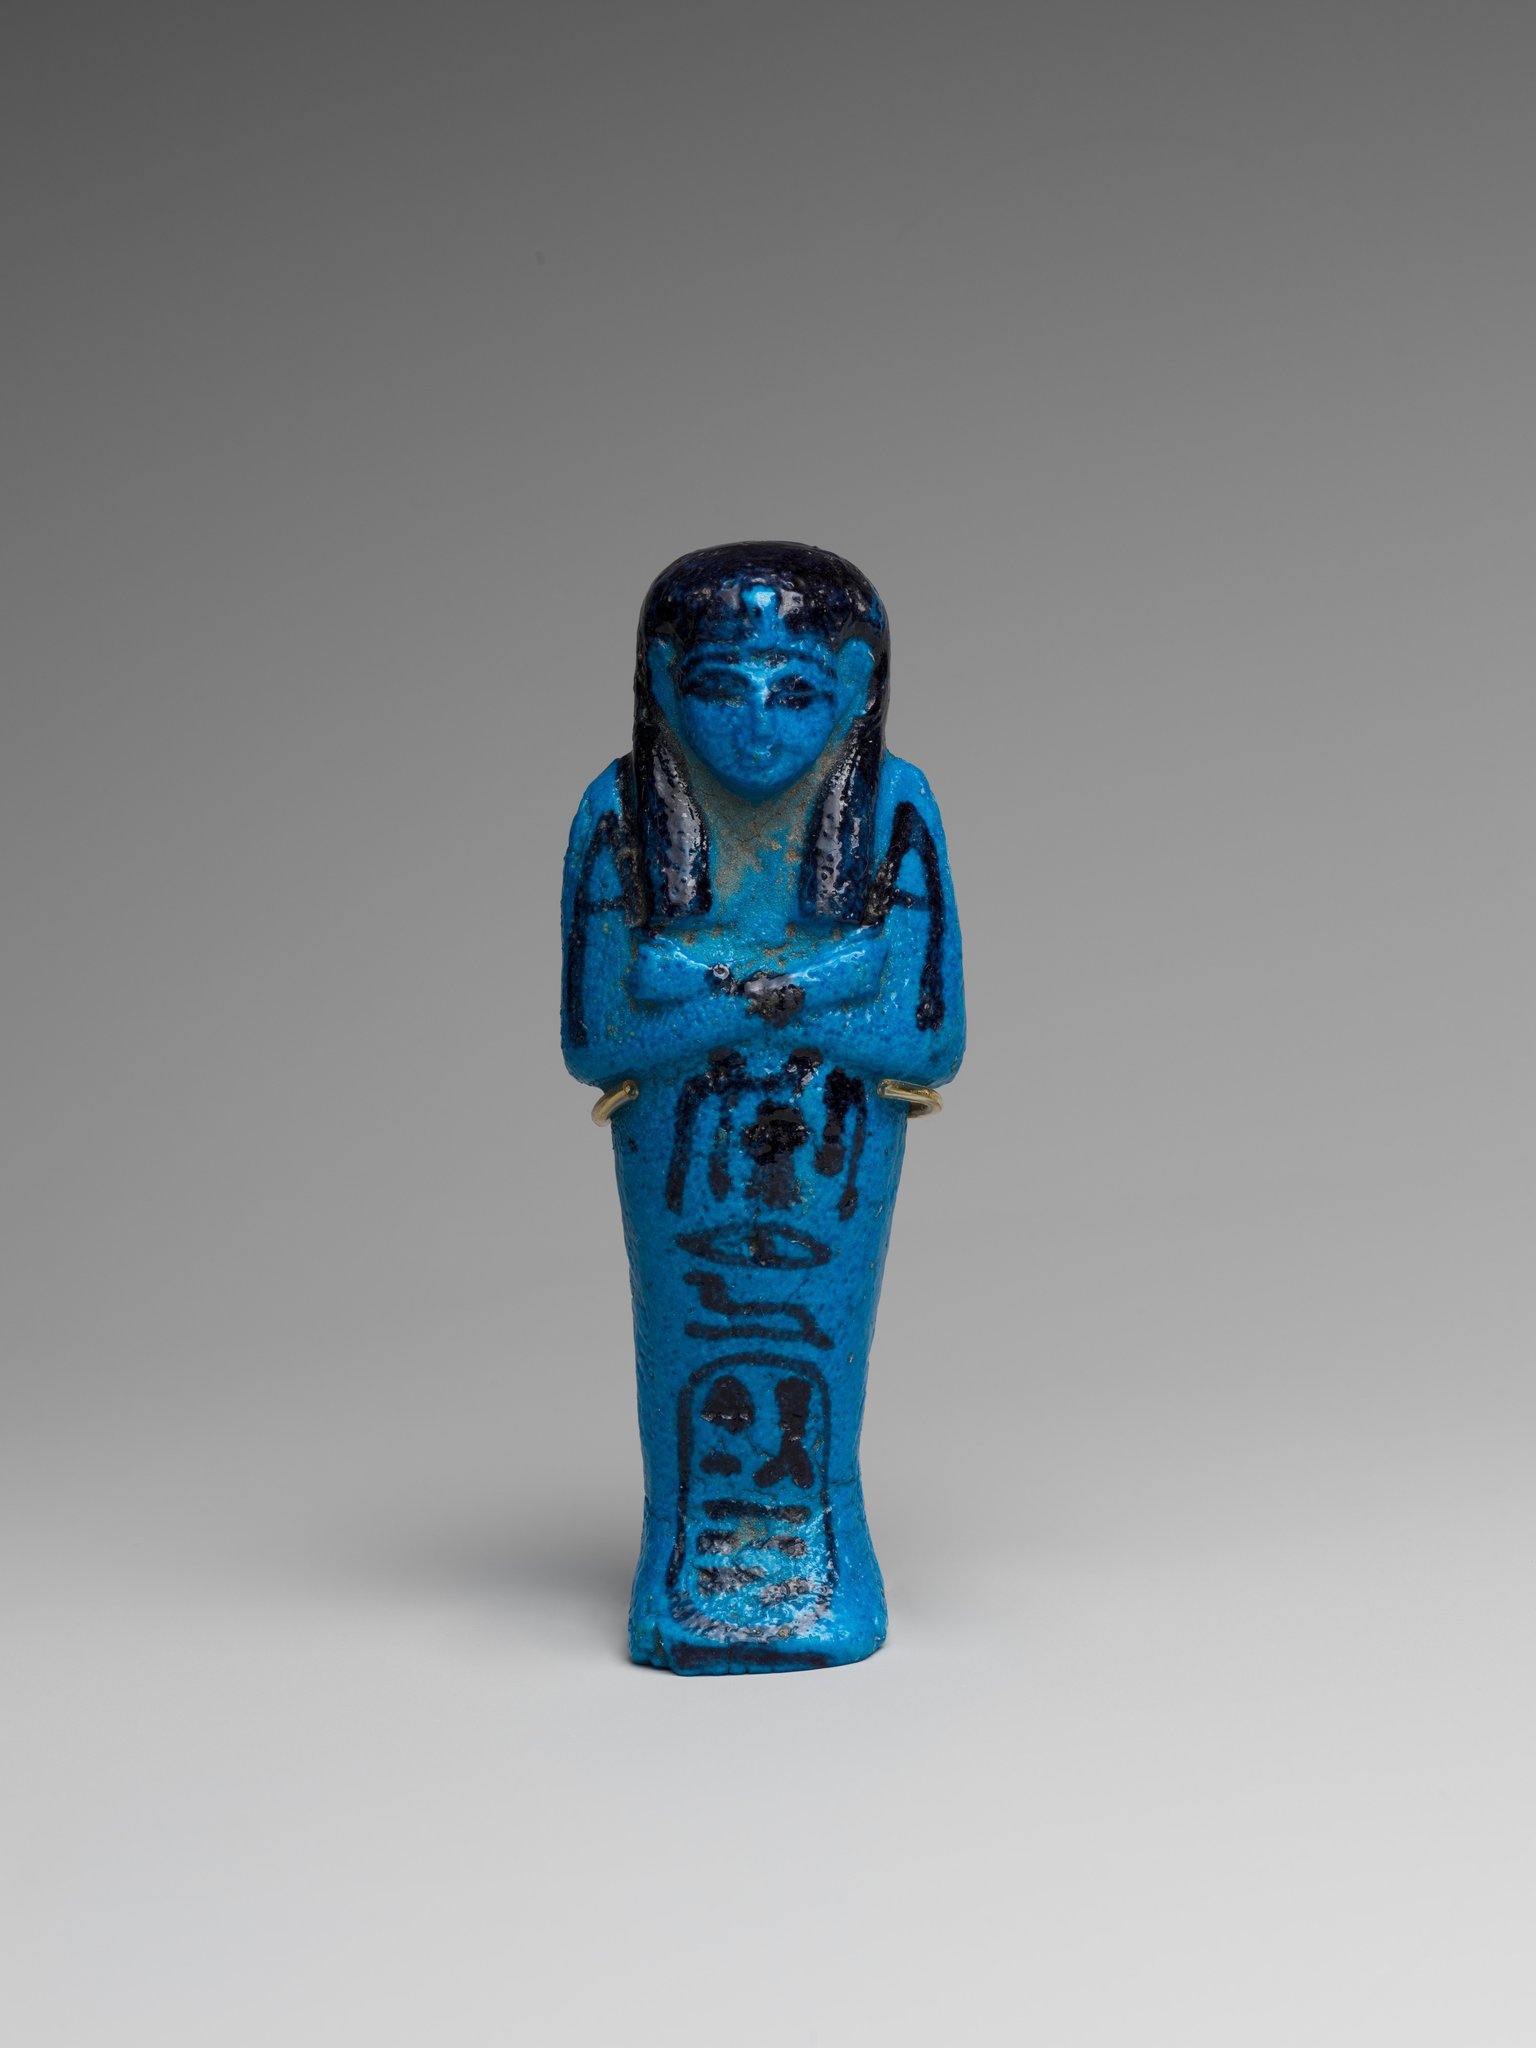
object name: shabti, queen henettawy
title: Shabti of the Adoratrice of Hathor ("Duahathor") Henettawy, wife of Painedjem I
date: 1064-1055 BCE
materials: faience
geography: upper egypt, thebes